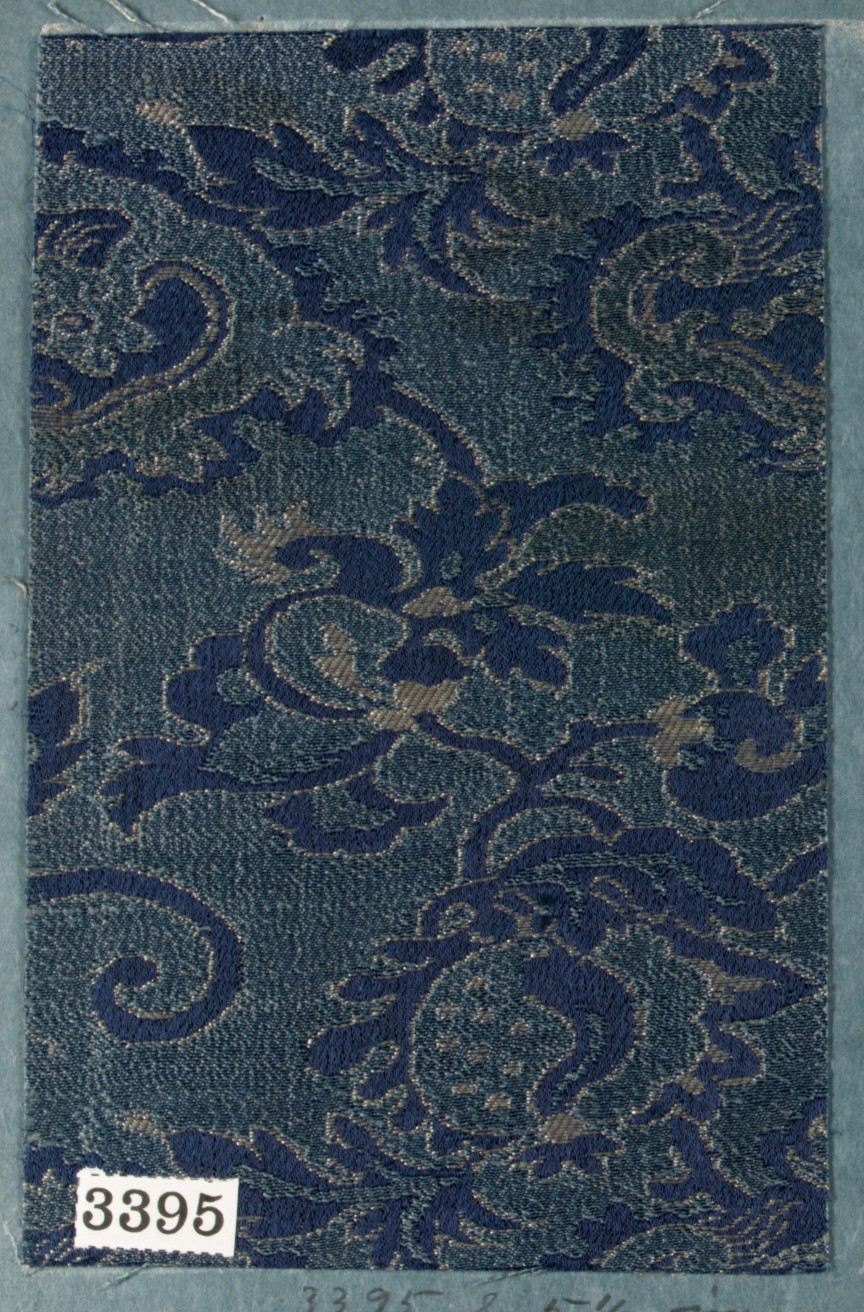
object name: textile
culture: japanese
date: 1801-1900